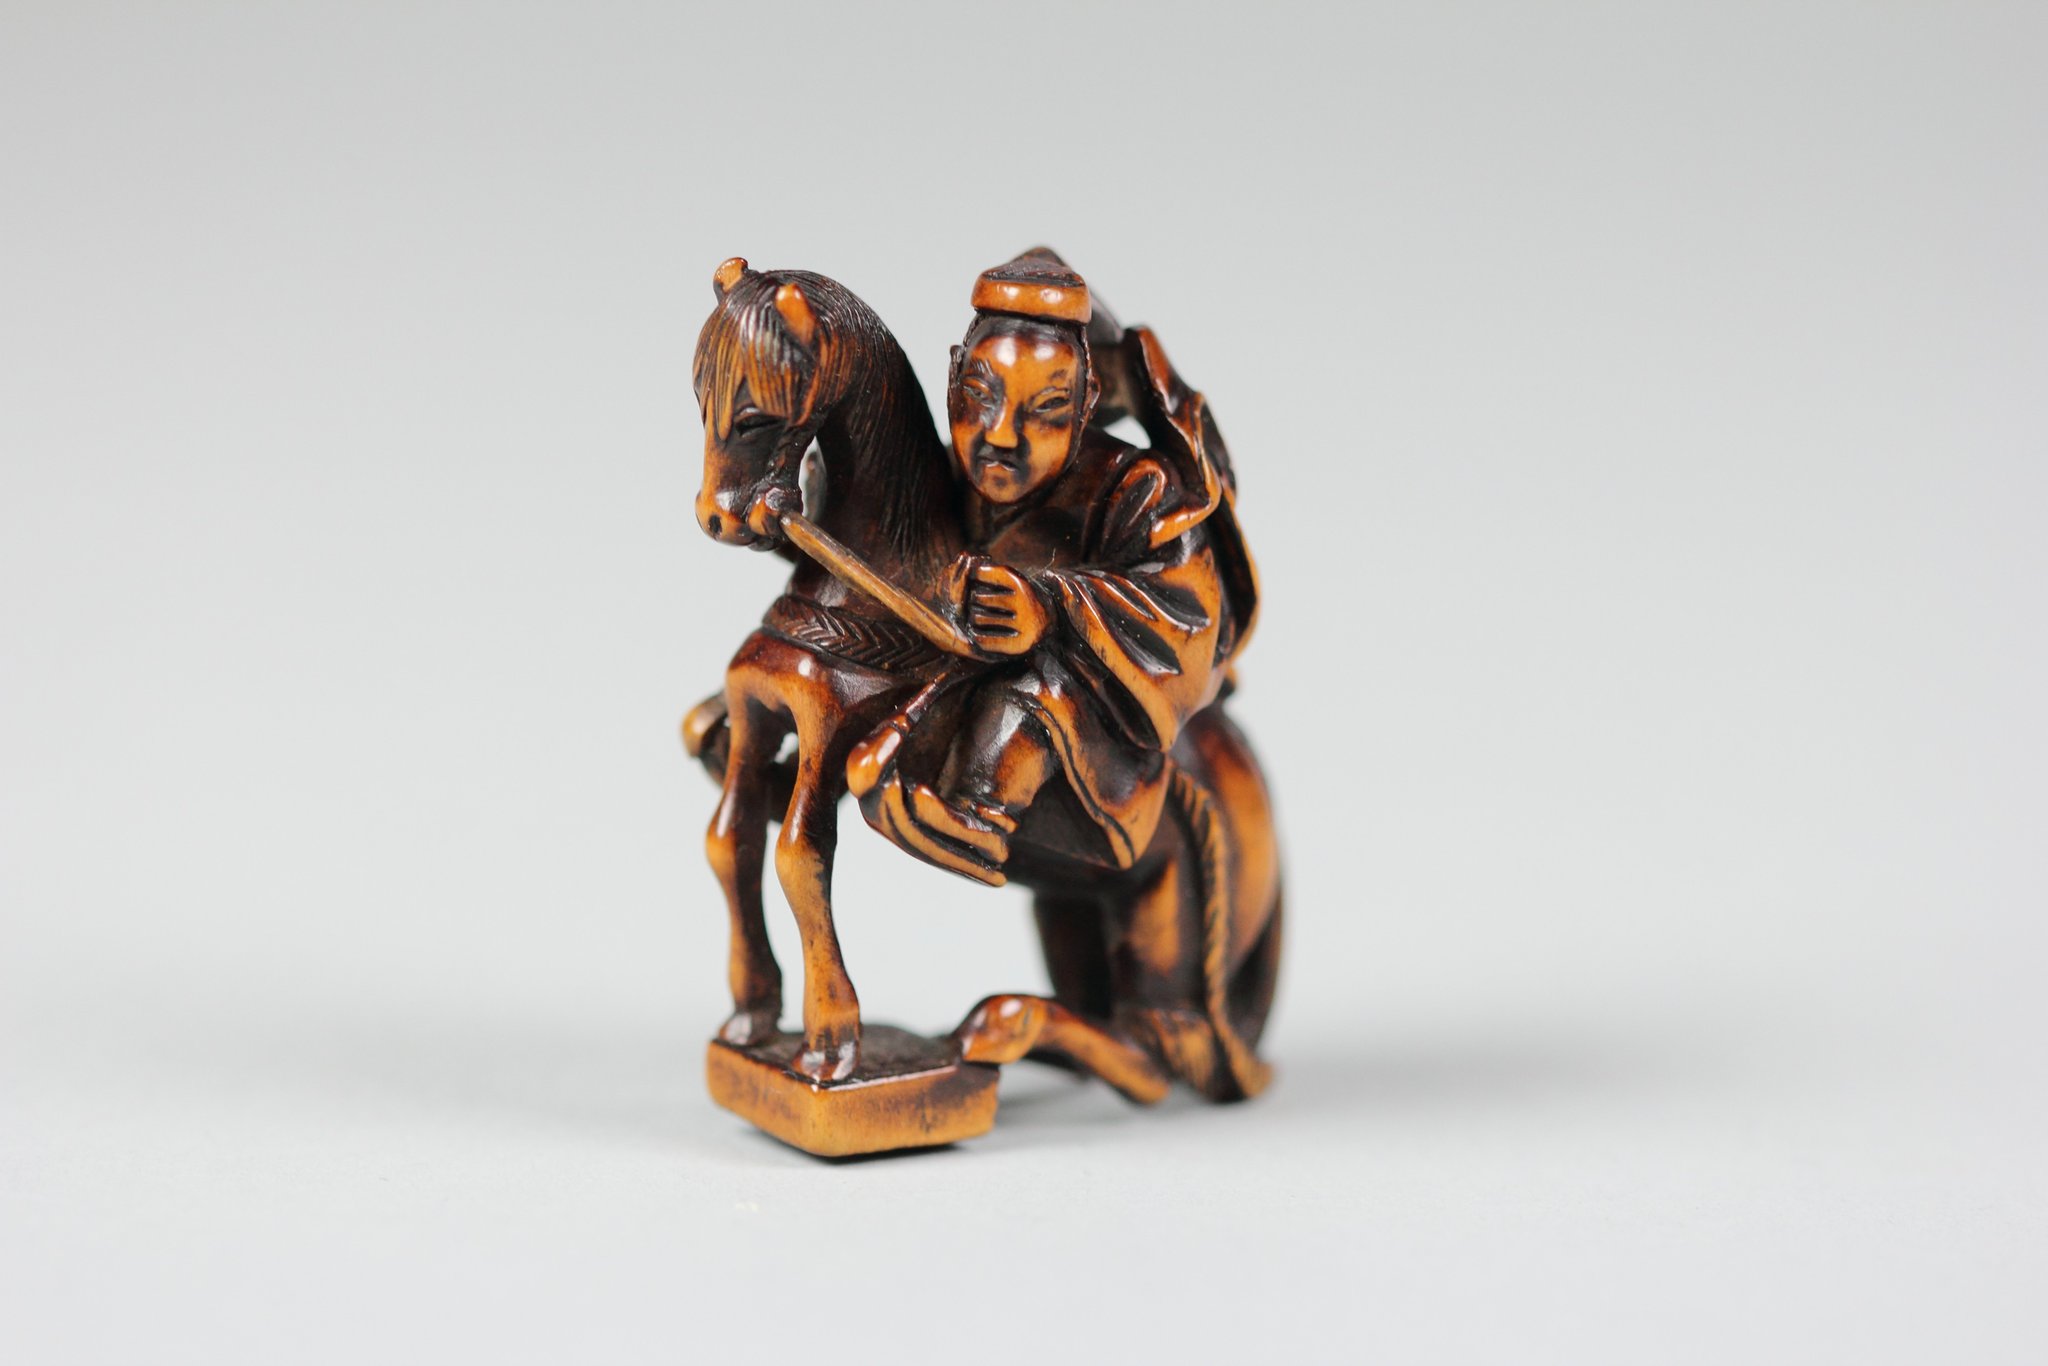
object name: netsuke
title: Netsuke of Equestrian Figure on a Go Board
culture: japanese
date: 1801-1900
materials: wood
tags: men,horses